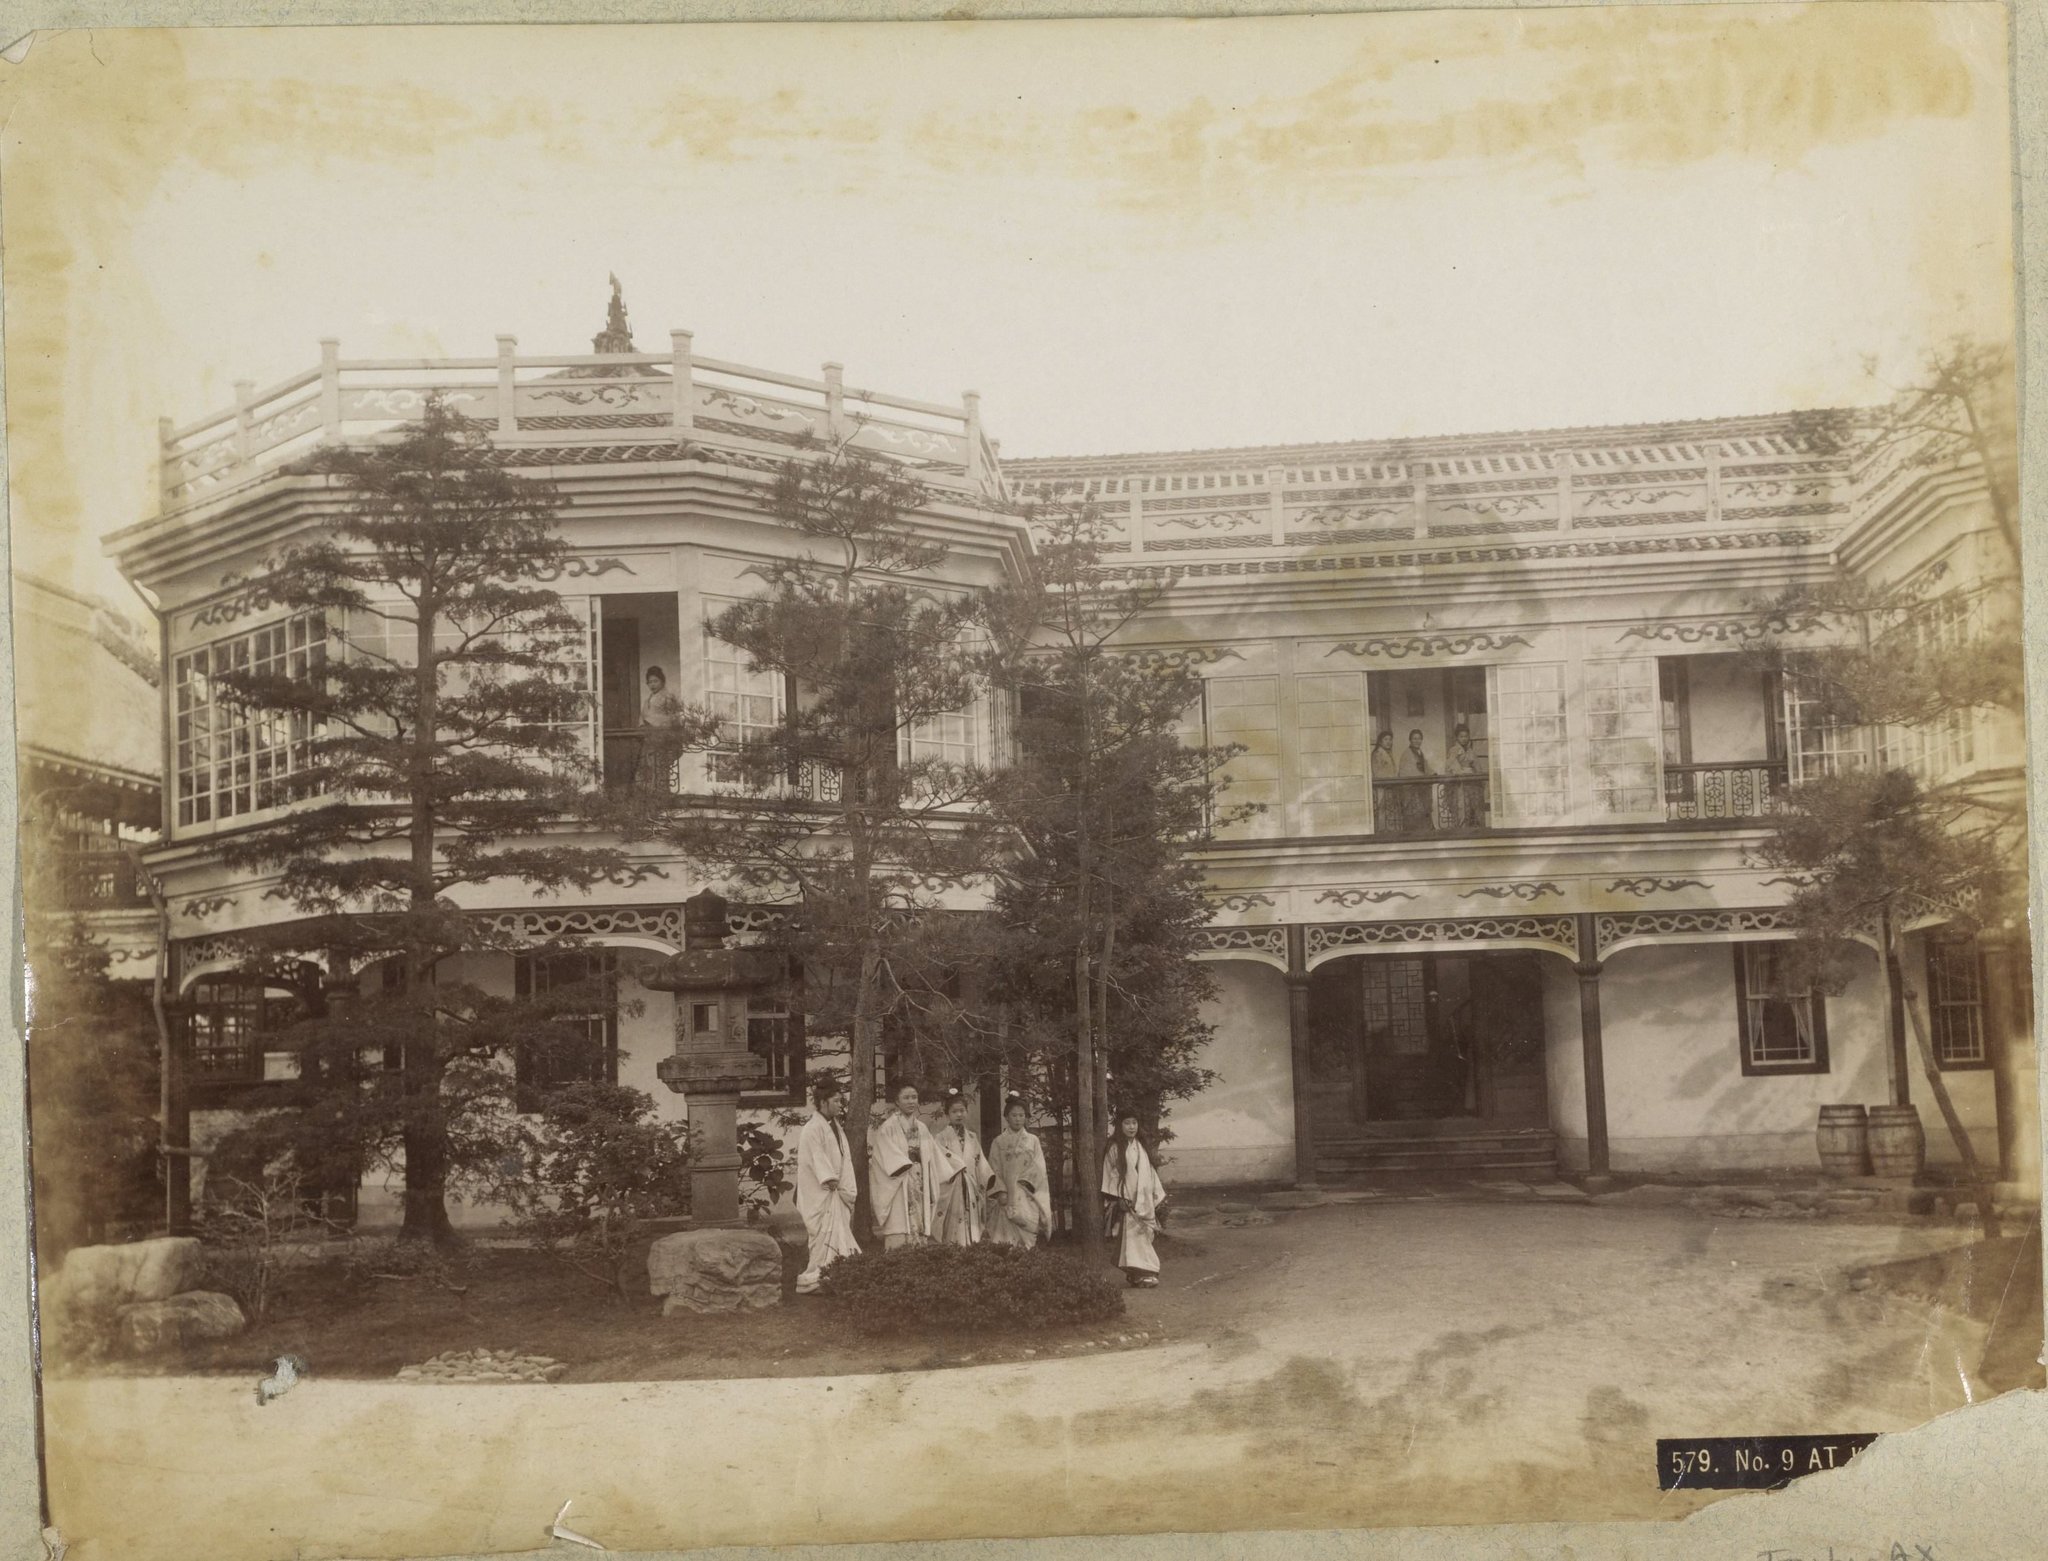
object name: photograph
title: At (...)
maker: Anonymous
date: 1870-1891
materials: paper, photographic support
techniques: albumen print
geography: japan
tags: brothel, courtesan, hetaera, japan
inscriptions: negative number: ‘579 No. 9’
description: Onderdeel van Fotoalbum van een reis naar Manilla.